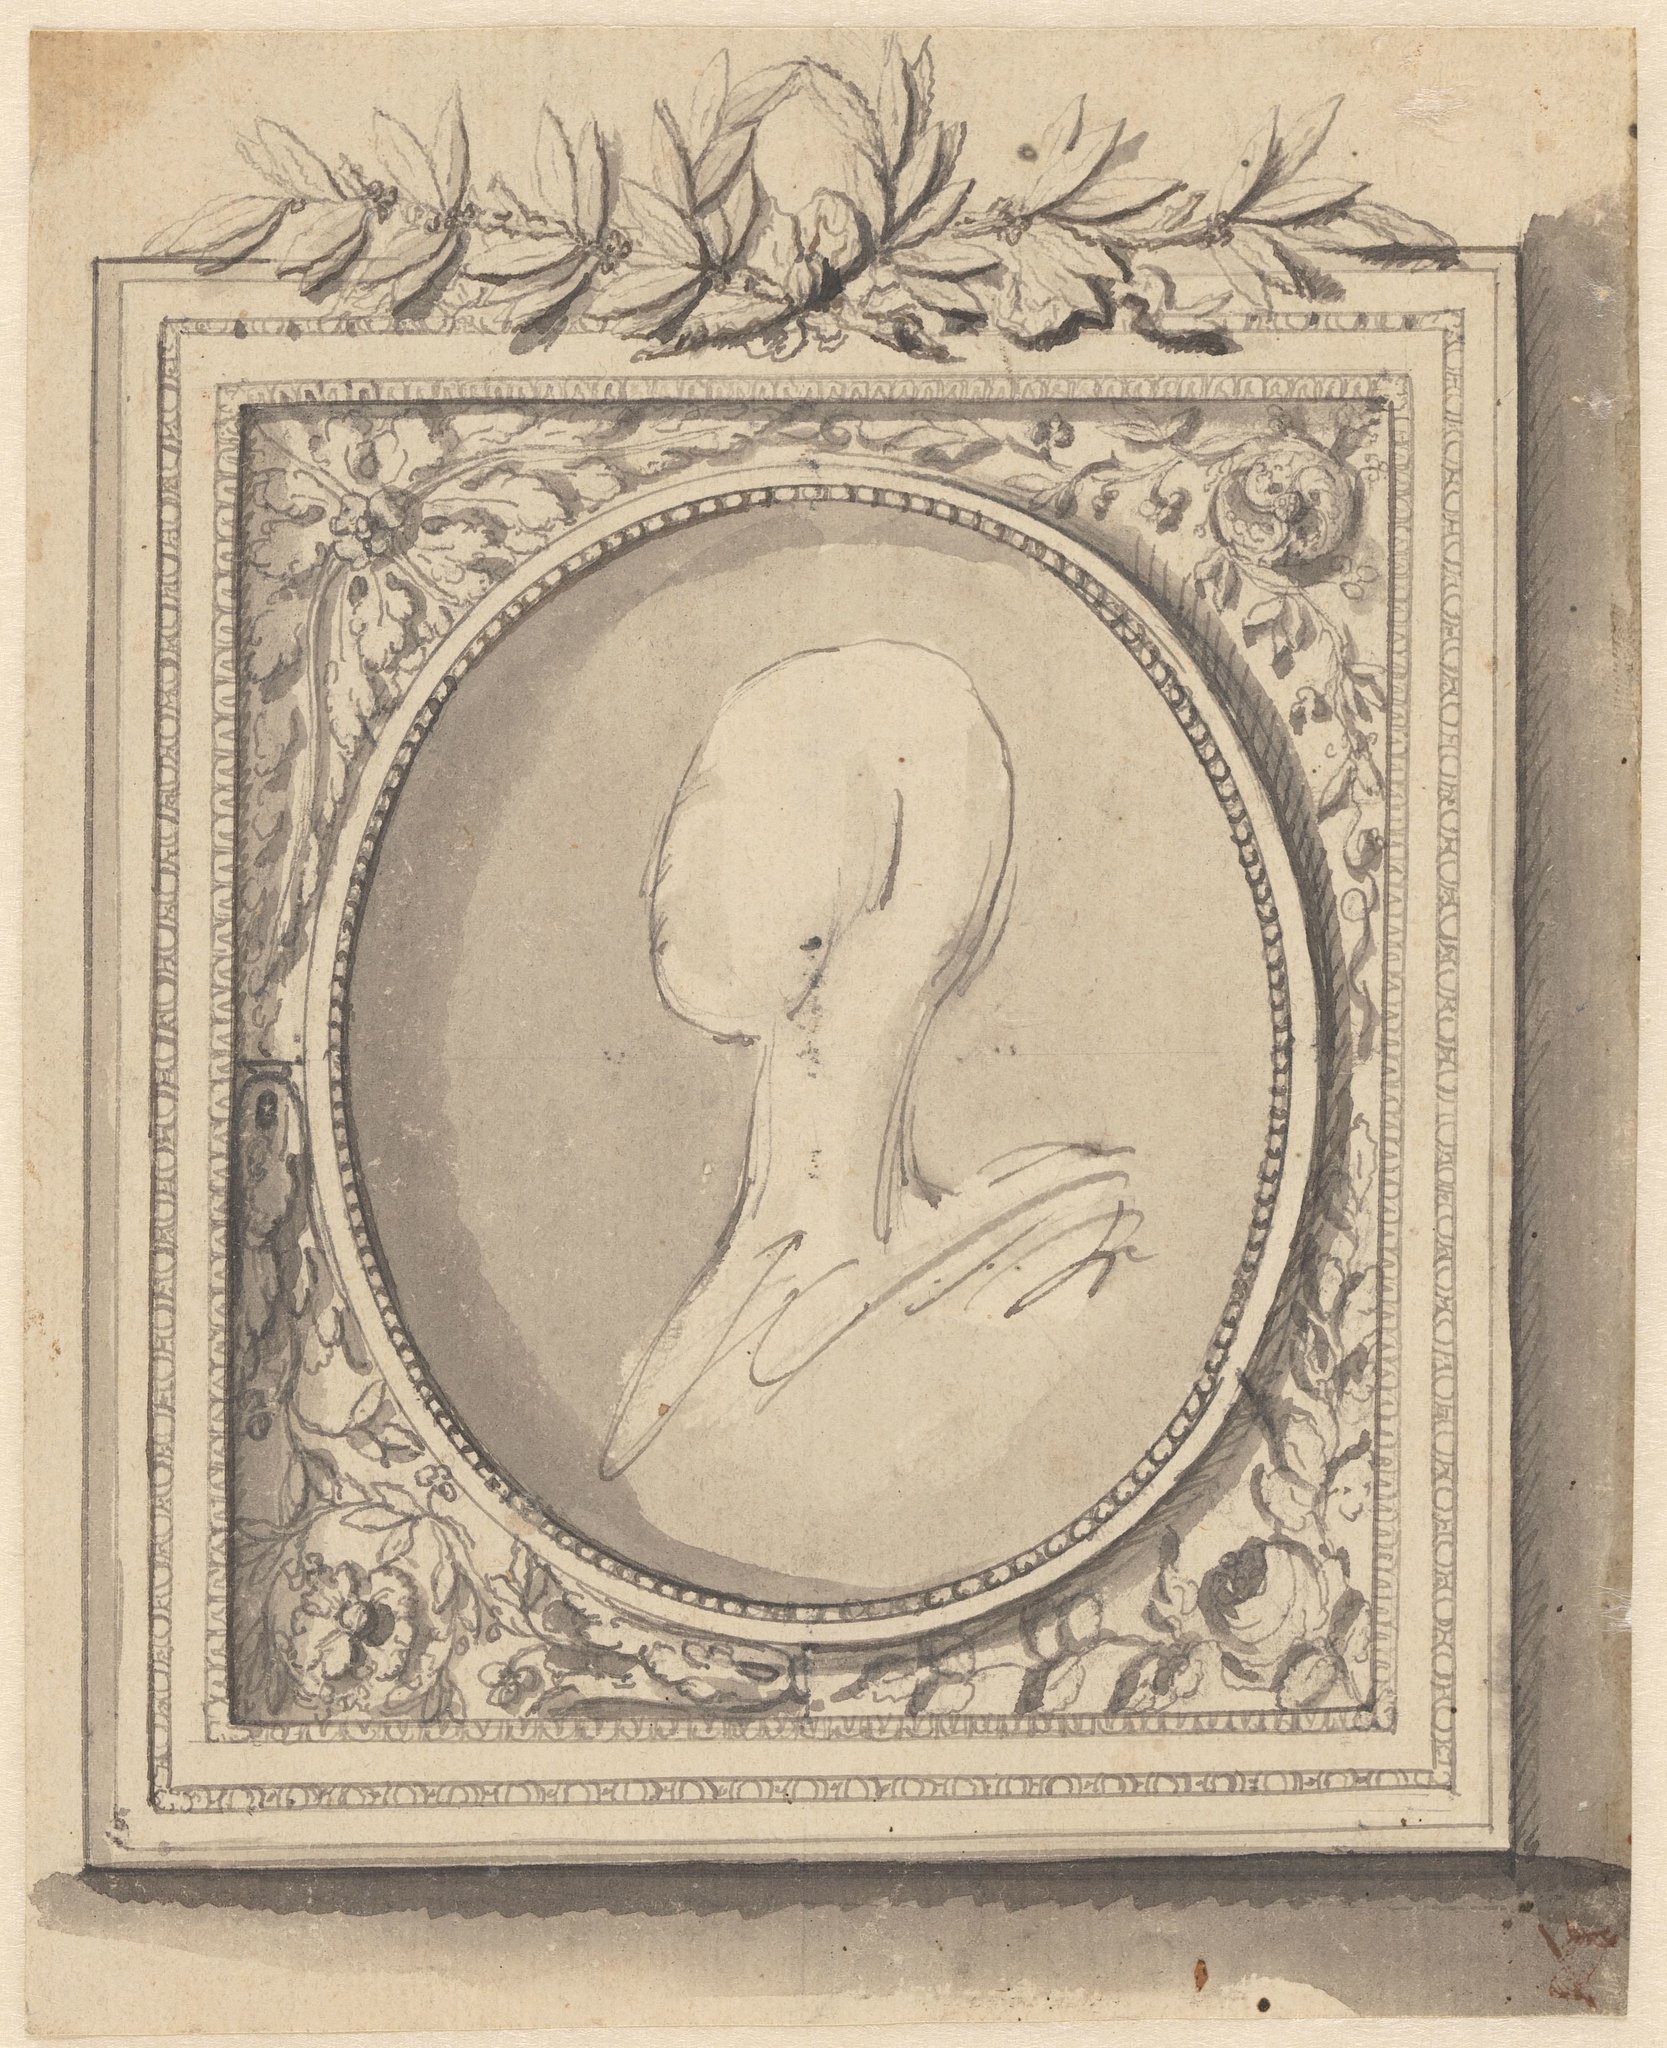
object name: drawing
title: Ontwerp voor een lijst voor een portret of camee, met vier alternatieve hoekoplossingen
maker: jean louis prieur (ii)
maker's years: 1732-1795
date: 1765-1775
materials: ink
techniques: brush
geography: paris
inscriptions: watermark: ‘rijk versierd wapenschild met gekruiste staven (?)’, collector's mark: ‘Lodewijk Houthakker (L. 3893)’